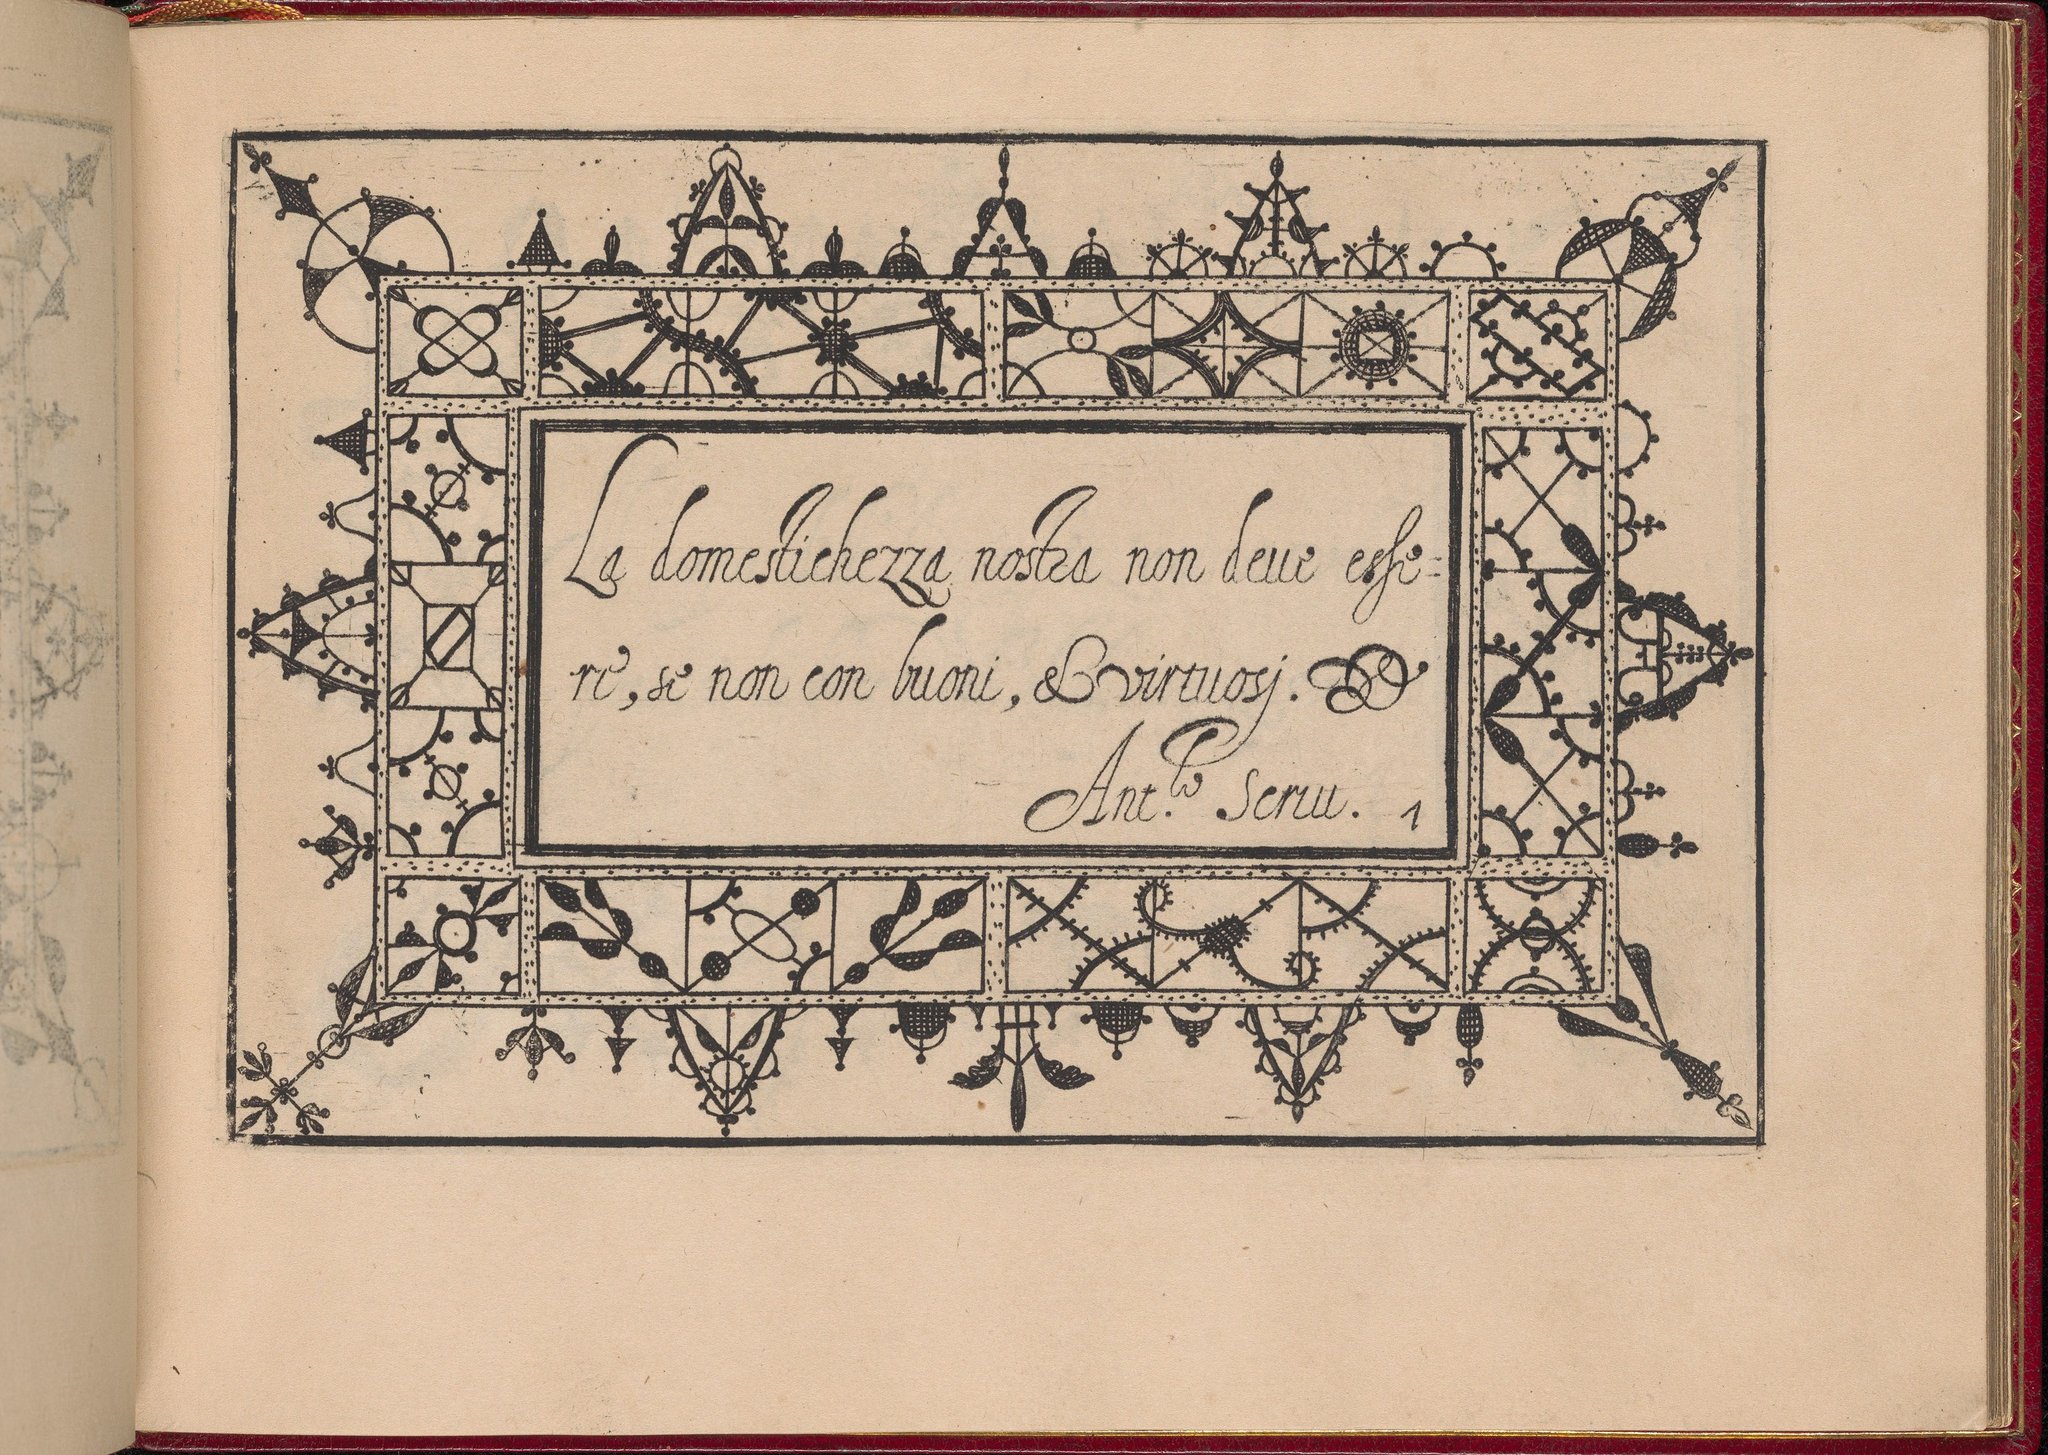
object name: book print ornament architecture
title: Ghirlanda: Di sei vaghi fiori scielti da piu famosi Giardini d'Italia, page 15 (recto)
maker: pietro paulo tozzi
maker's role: designer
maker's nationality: italian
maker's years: 1593-1628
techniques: drawing, etching